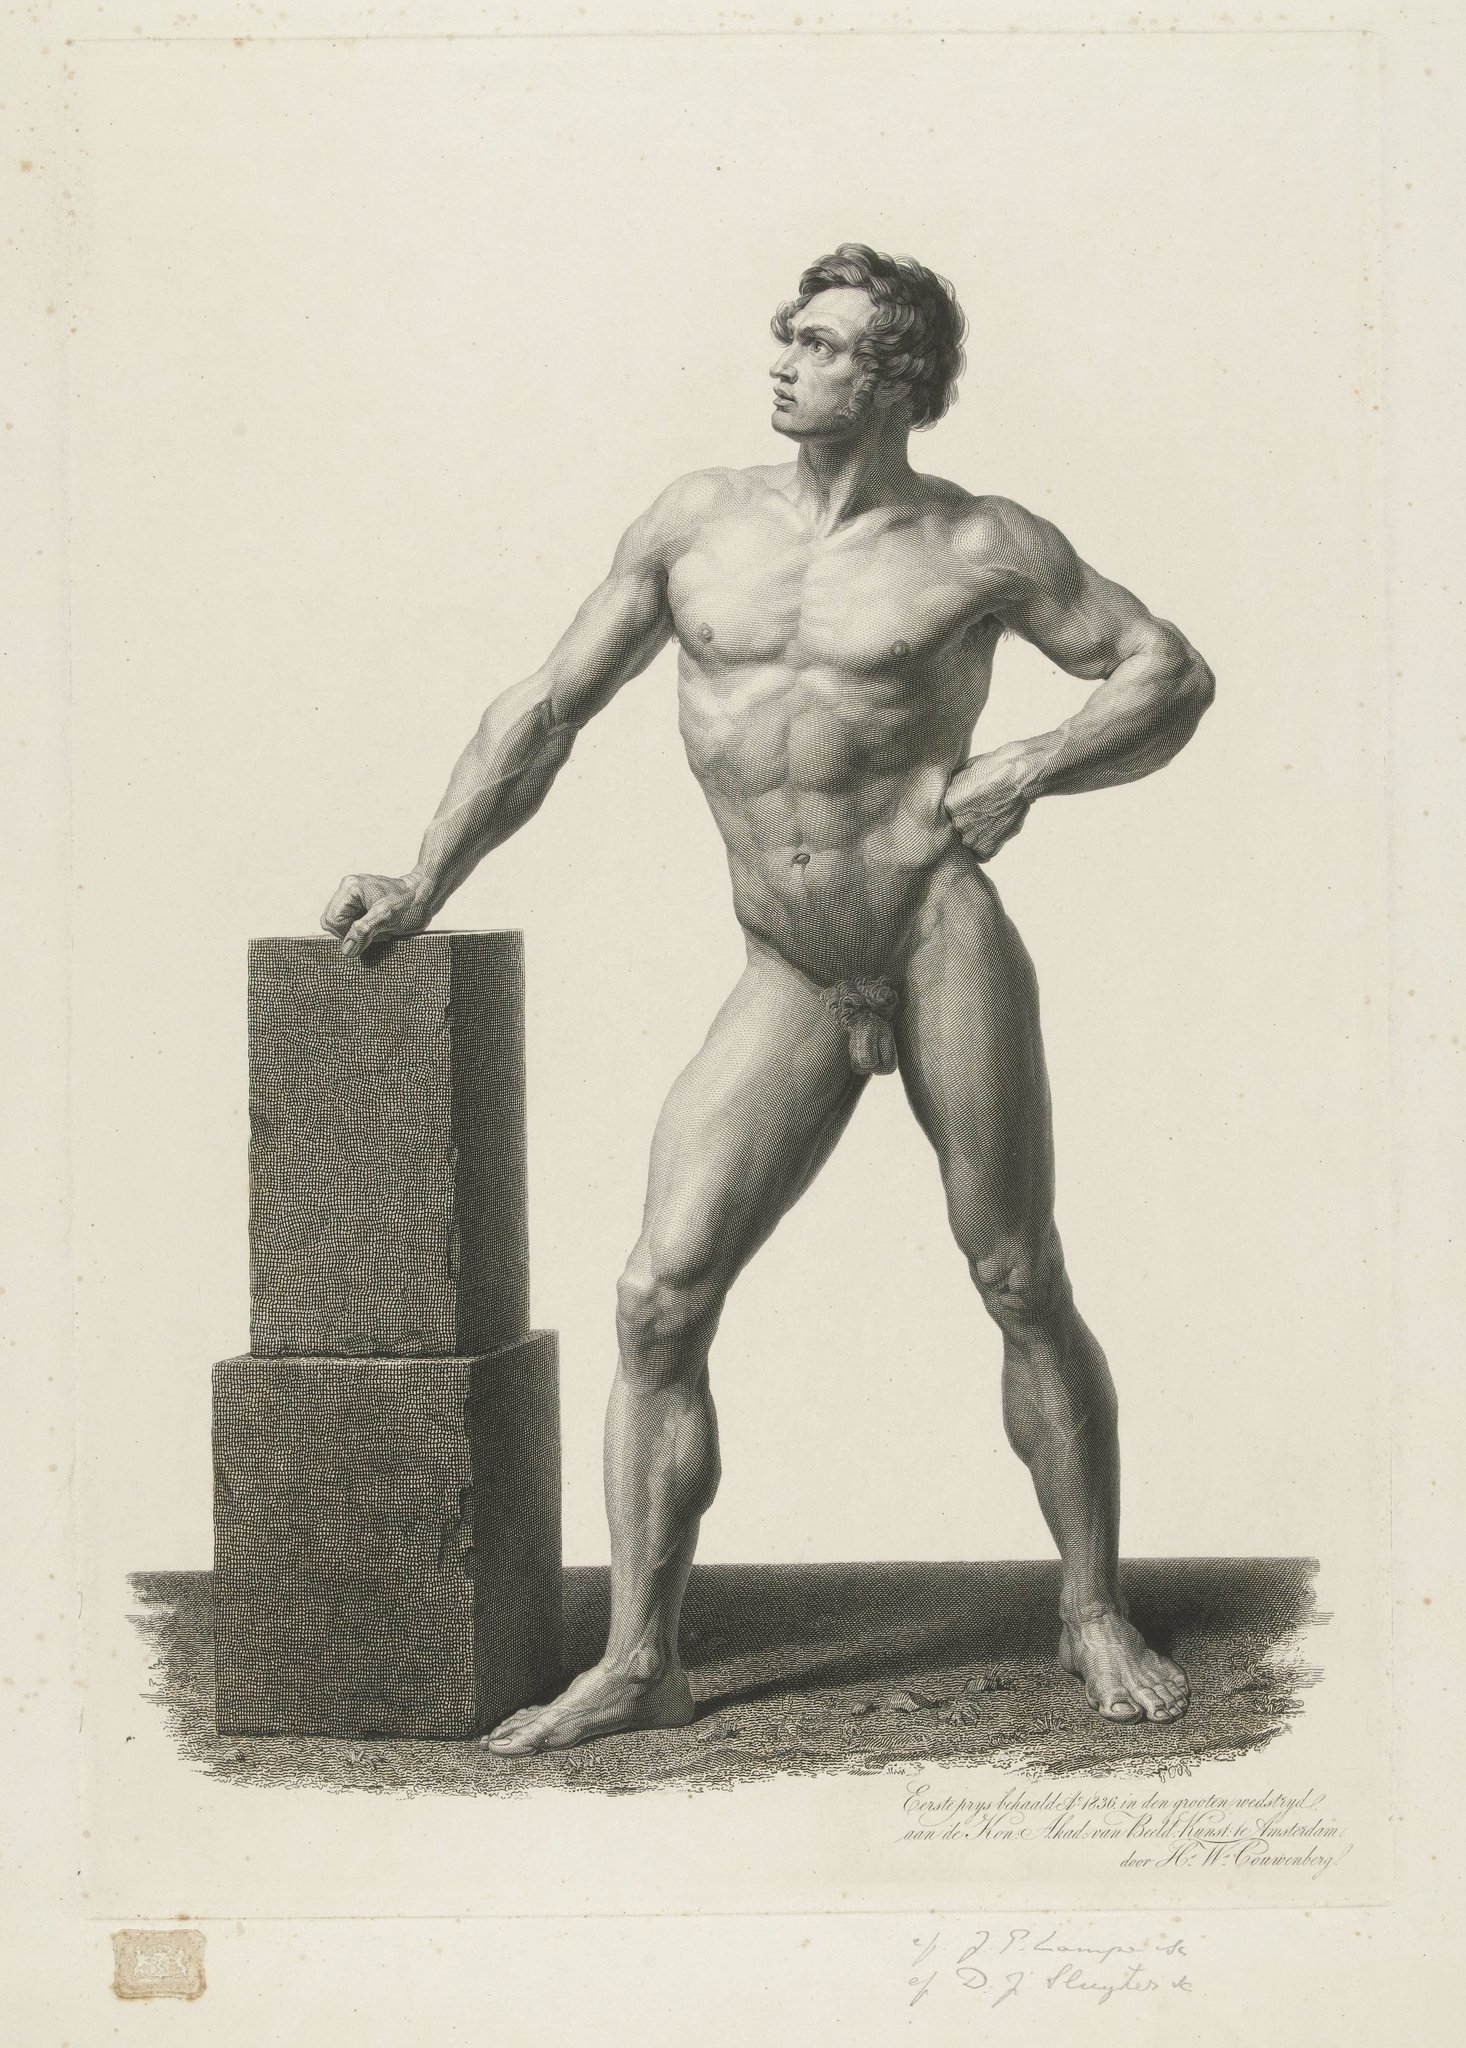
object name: print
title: Naakte man, met de rechterhand op een stenen blok leunend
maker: henricus wilhelmus couwenberg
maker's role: draughtsman, print maker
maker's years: 1814-1845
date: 1836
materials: paper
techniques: engraving, etching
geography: amsterdam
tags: the (nude) human figure; 'corpo humano' (ripa) (+ standing)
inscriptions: collector's mark: Lugt 2228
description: Prijswinnende prent bij "den grooten wedstrijd aan de Kon. Akad. van Beeld. Kunst. te Amsterdam" in het jaar 1836.